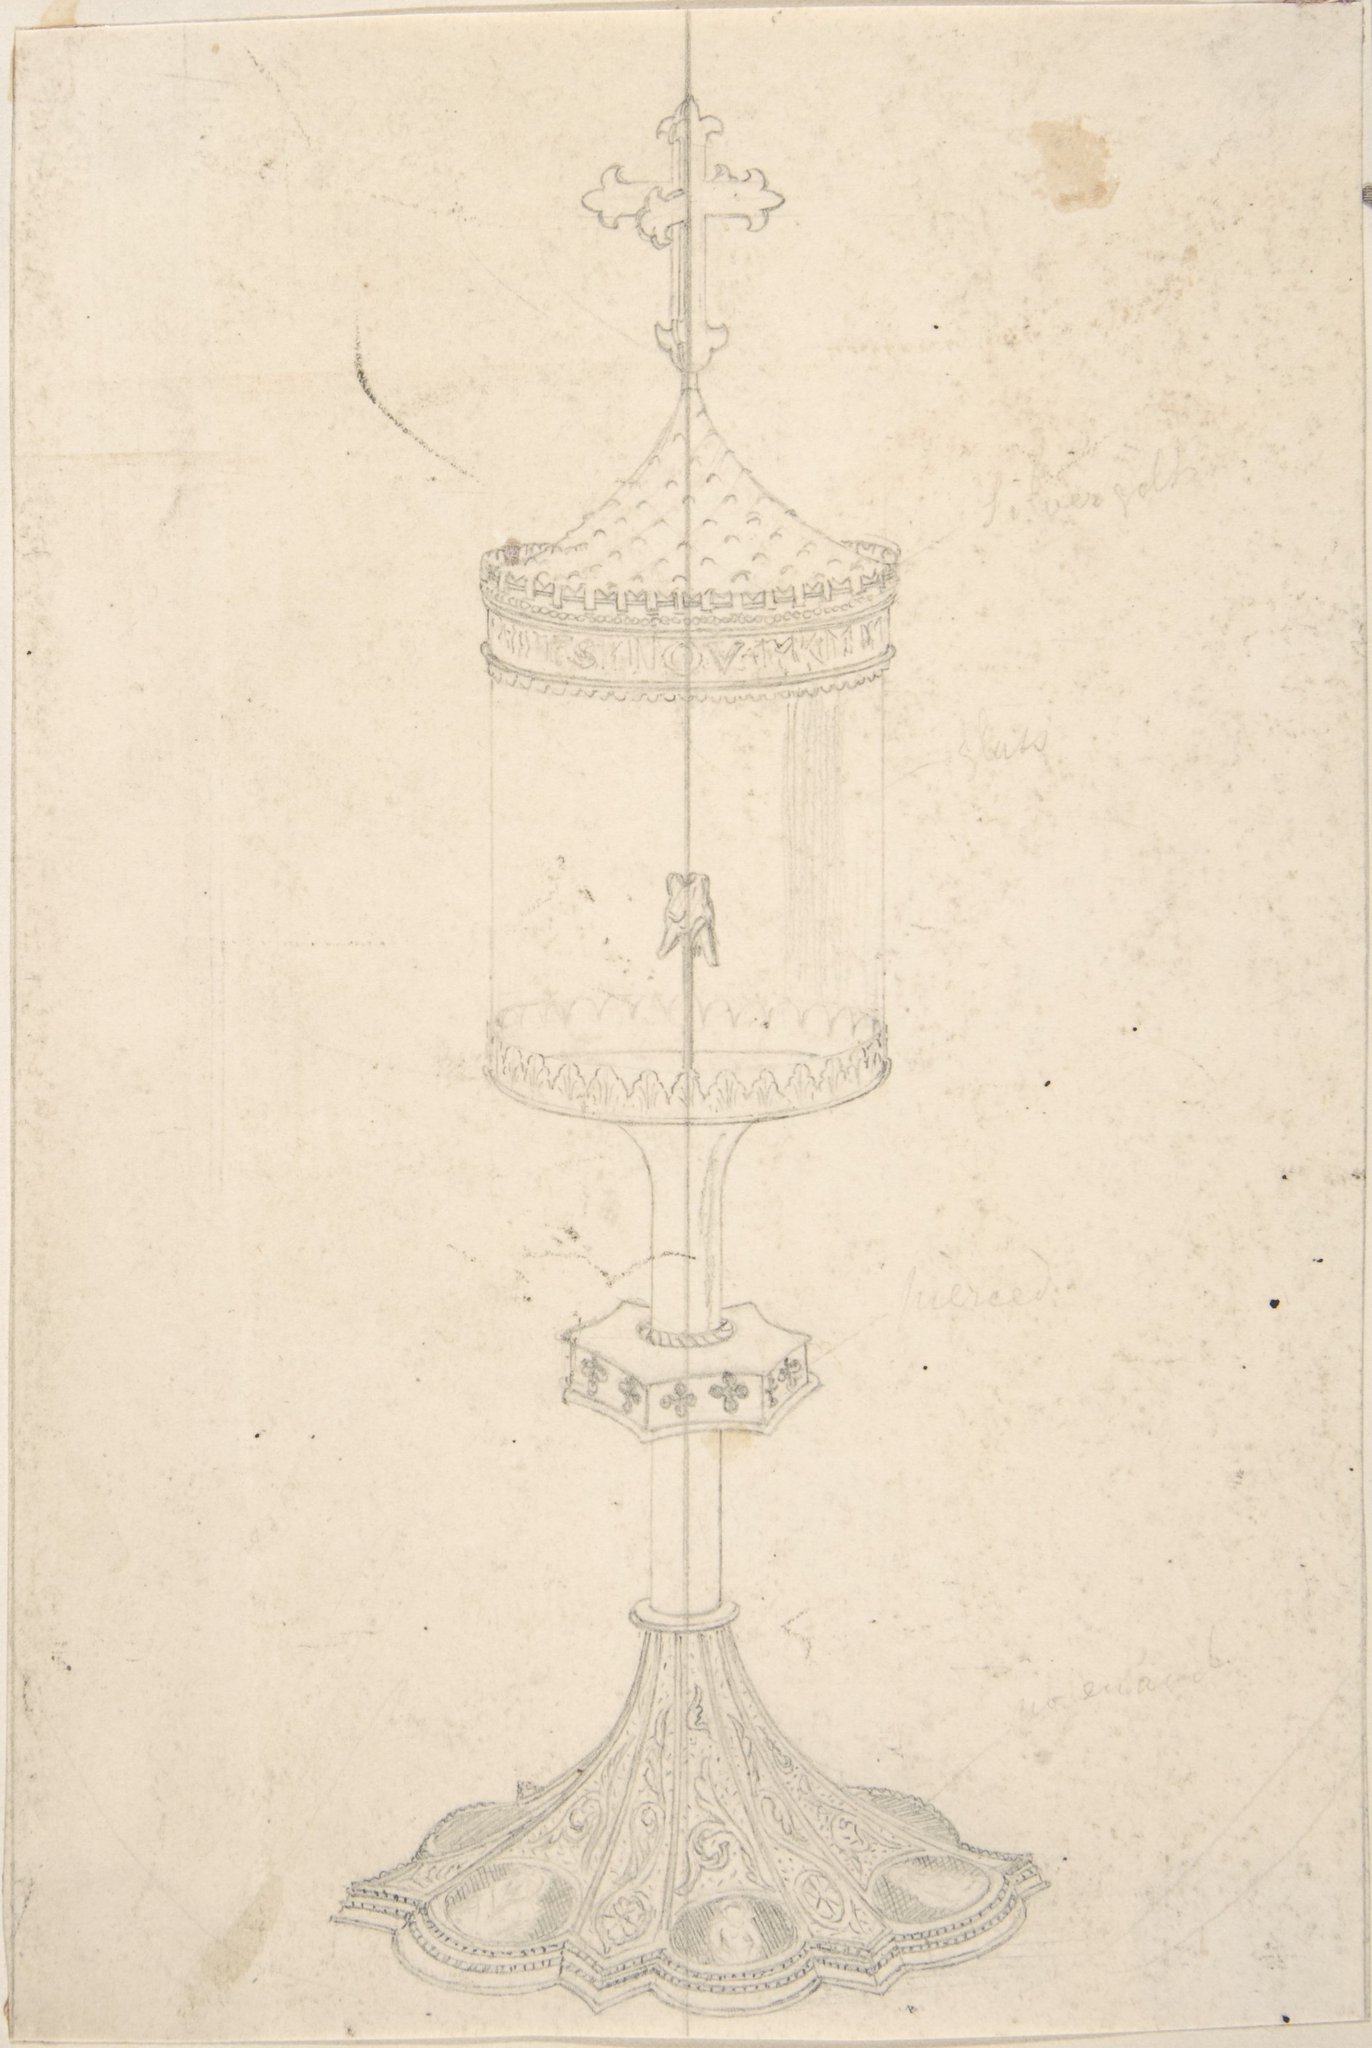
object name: drawing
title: Reliquary Containing a Tooth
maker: anonymous, british, 19th century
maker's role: artist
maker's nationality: british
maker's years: 1800-1900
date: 1851-1900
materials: graphite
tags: reliquaries